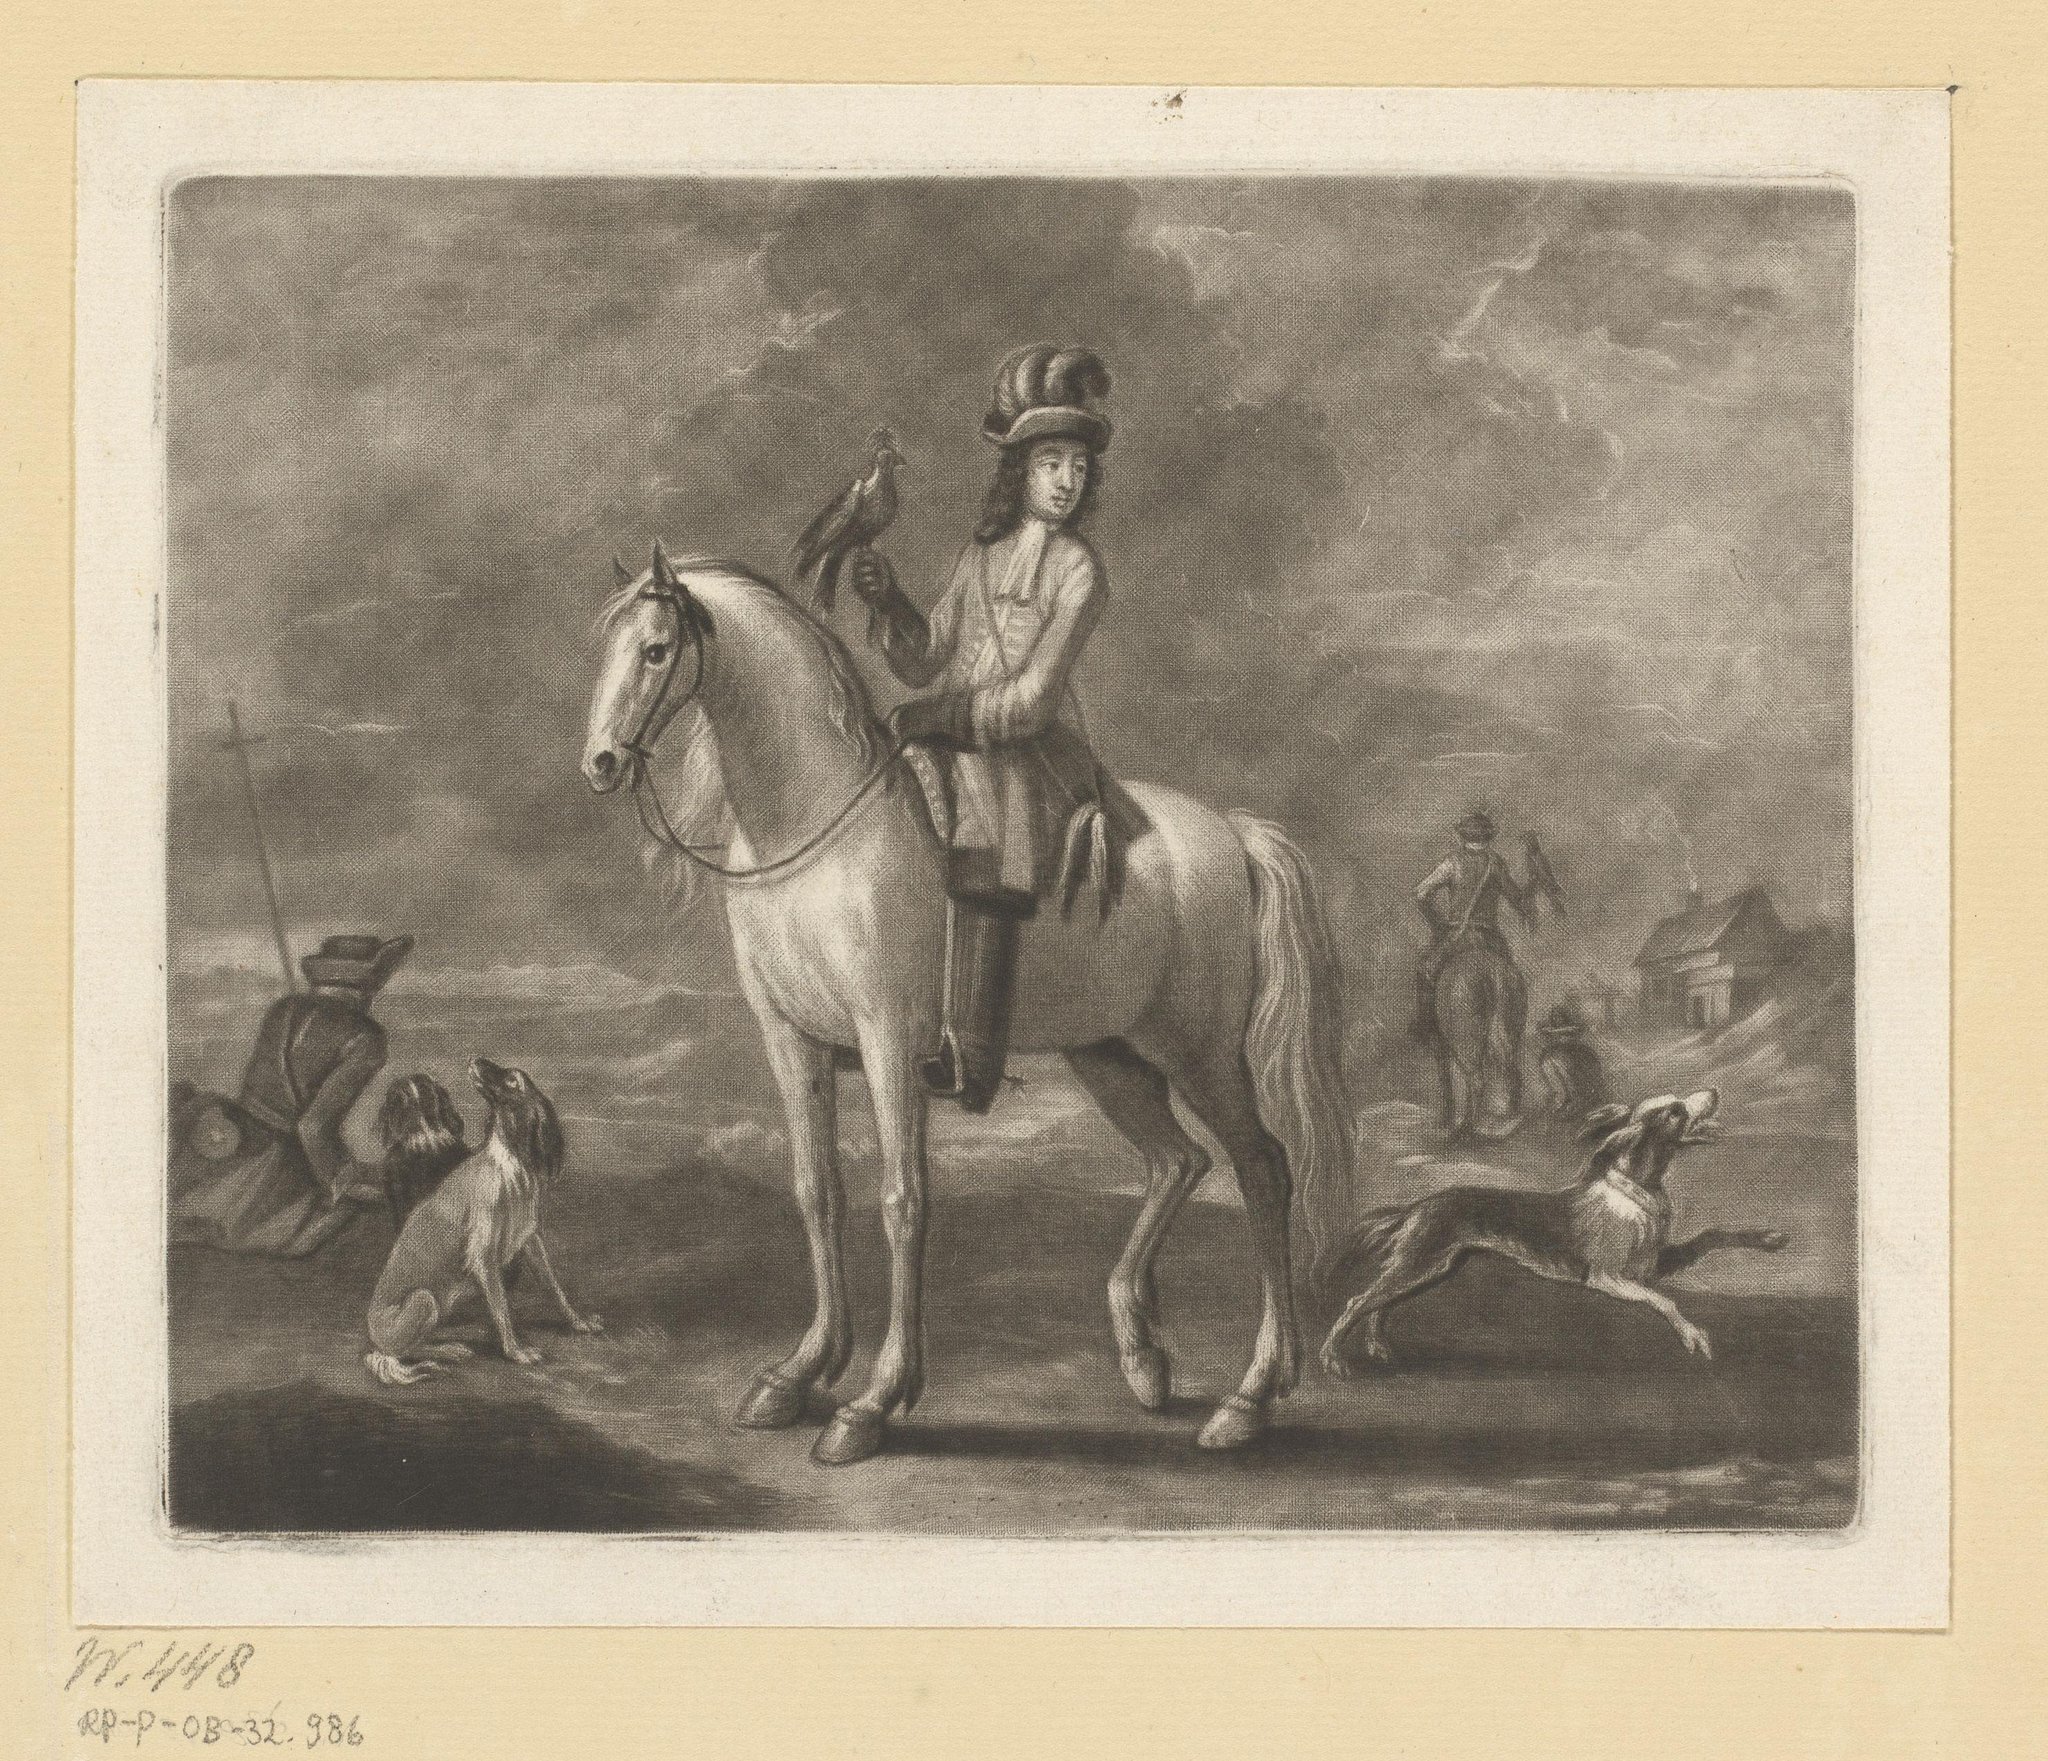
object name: print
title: Mannen te paard op valkenjacht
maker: john smith (prentmaker/ uitgever)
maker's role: print maker, publisher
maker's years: 1652-1743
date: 1662-1742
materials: paper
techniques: mezzotint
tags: predatory birds: falcon, assembling, 'départ pour la chasse'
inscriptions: collector's mark: Lugt 240